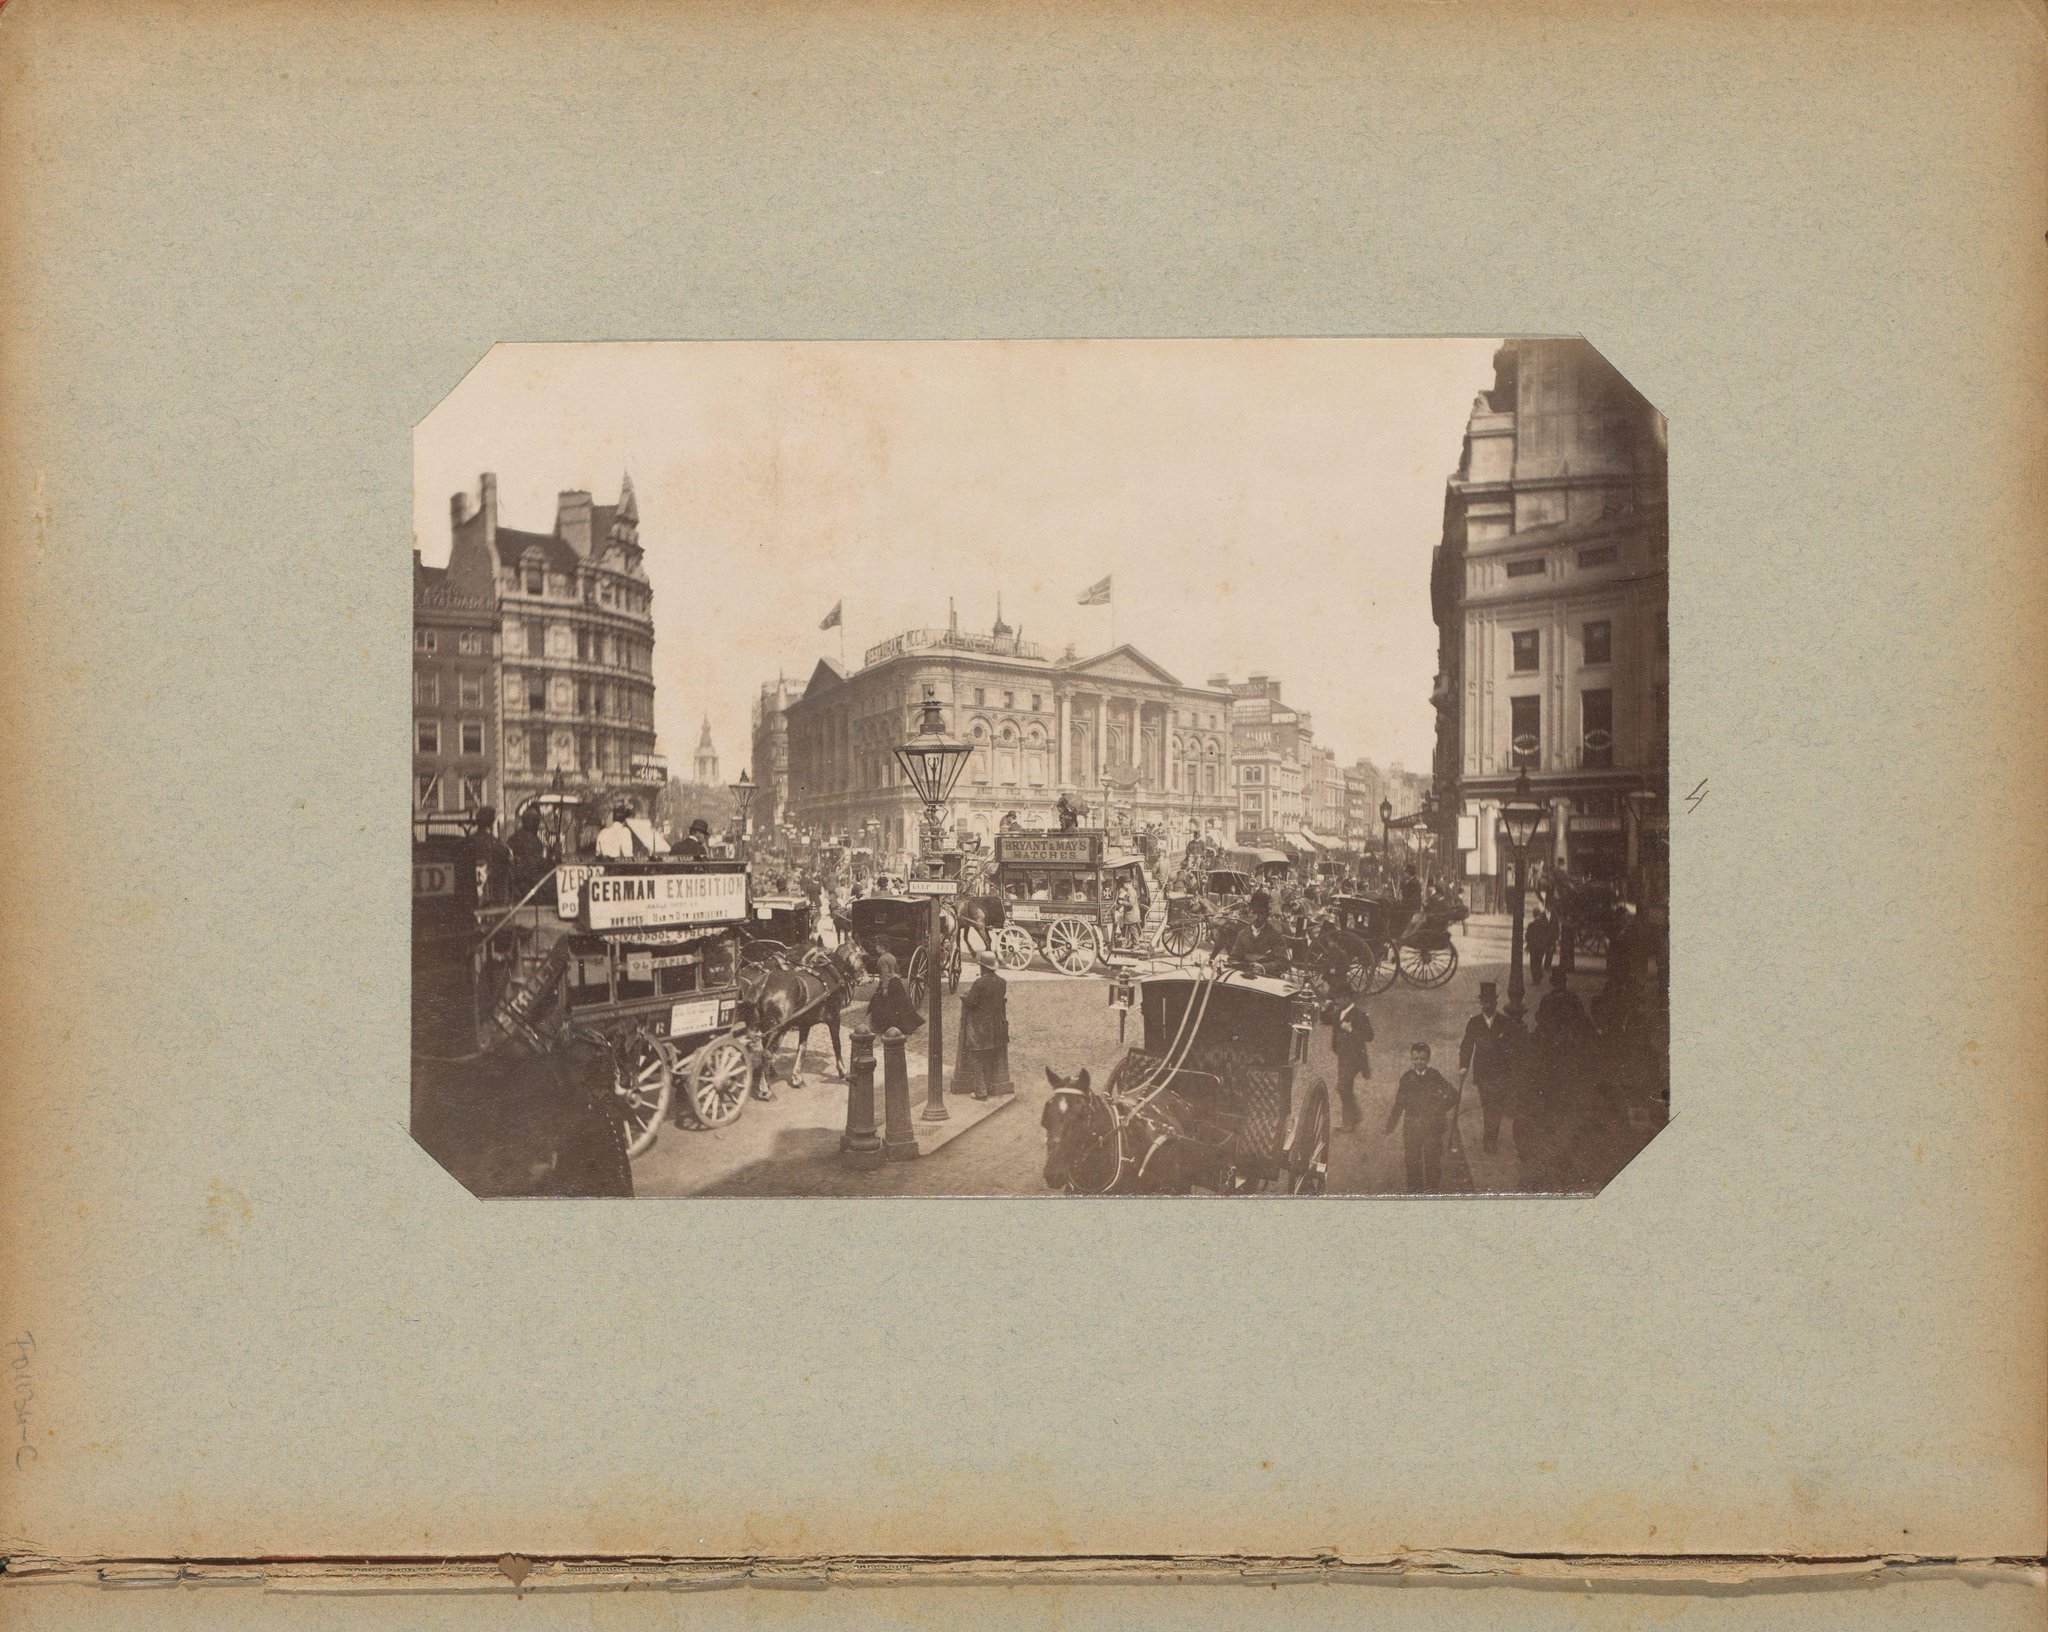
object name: album leaf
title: London Pavillon en paardenkoetsen met reclame voor de German Exhibition op Piccadilly Circus in Londen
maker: Anonymous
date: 1891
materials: paper, photographic support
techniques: albumen print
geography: london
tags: four-wheeled, animal-drawn vehicle, e.g.: cab, carriage, coach (+ conveyance for transport of persons), street (+ city(-scape) with figures, staffage), london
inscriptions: number: ‘7844’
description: Onderdeel van Reisalbum met bezienswaardigheden in Engeland, Zwitserland, Frankrijk en Duitsland.